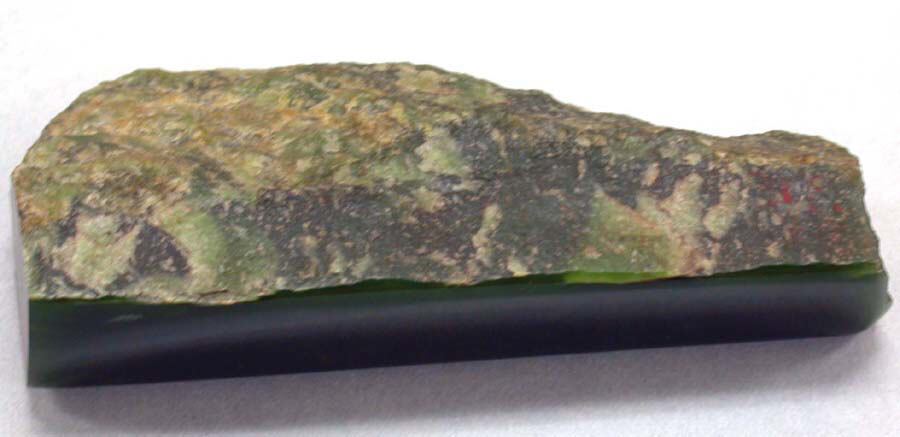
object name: fragment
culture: new zealander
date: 1902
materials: jade